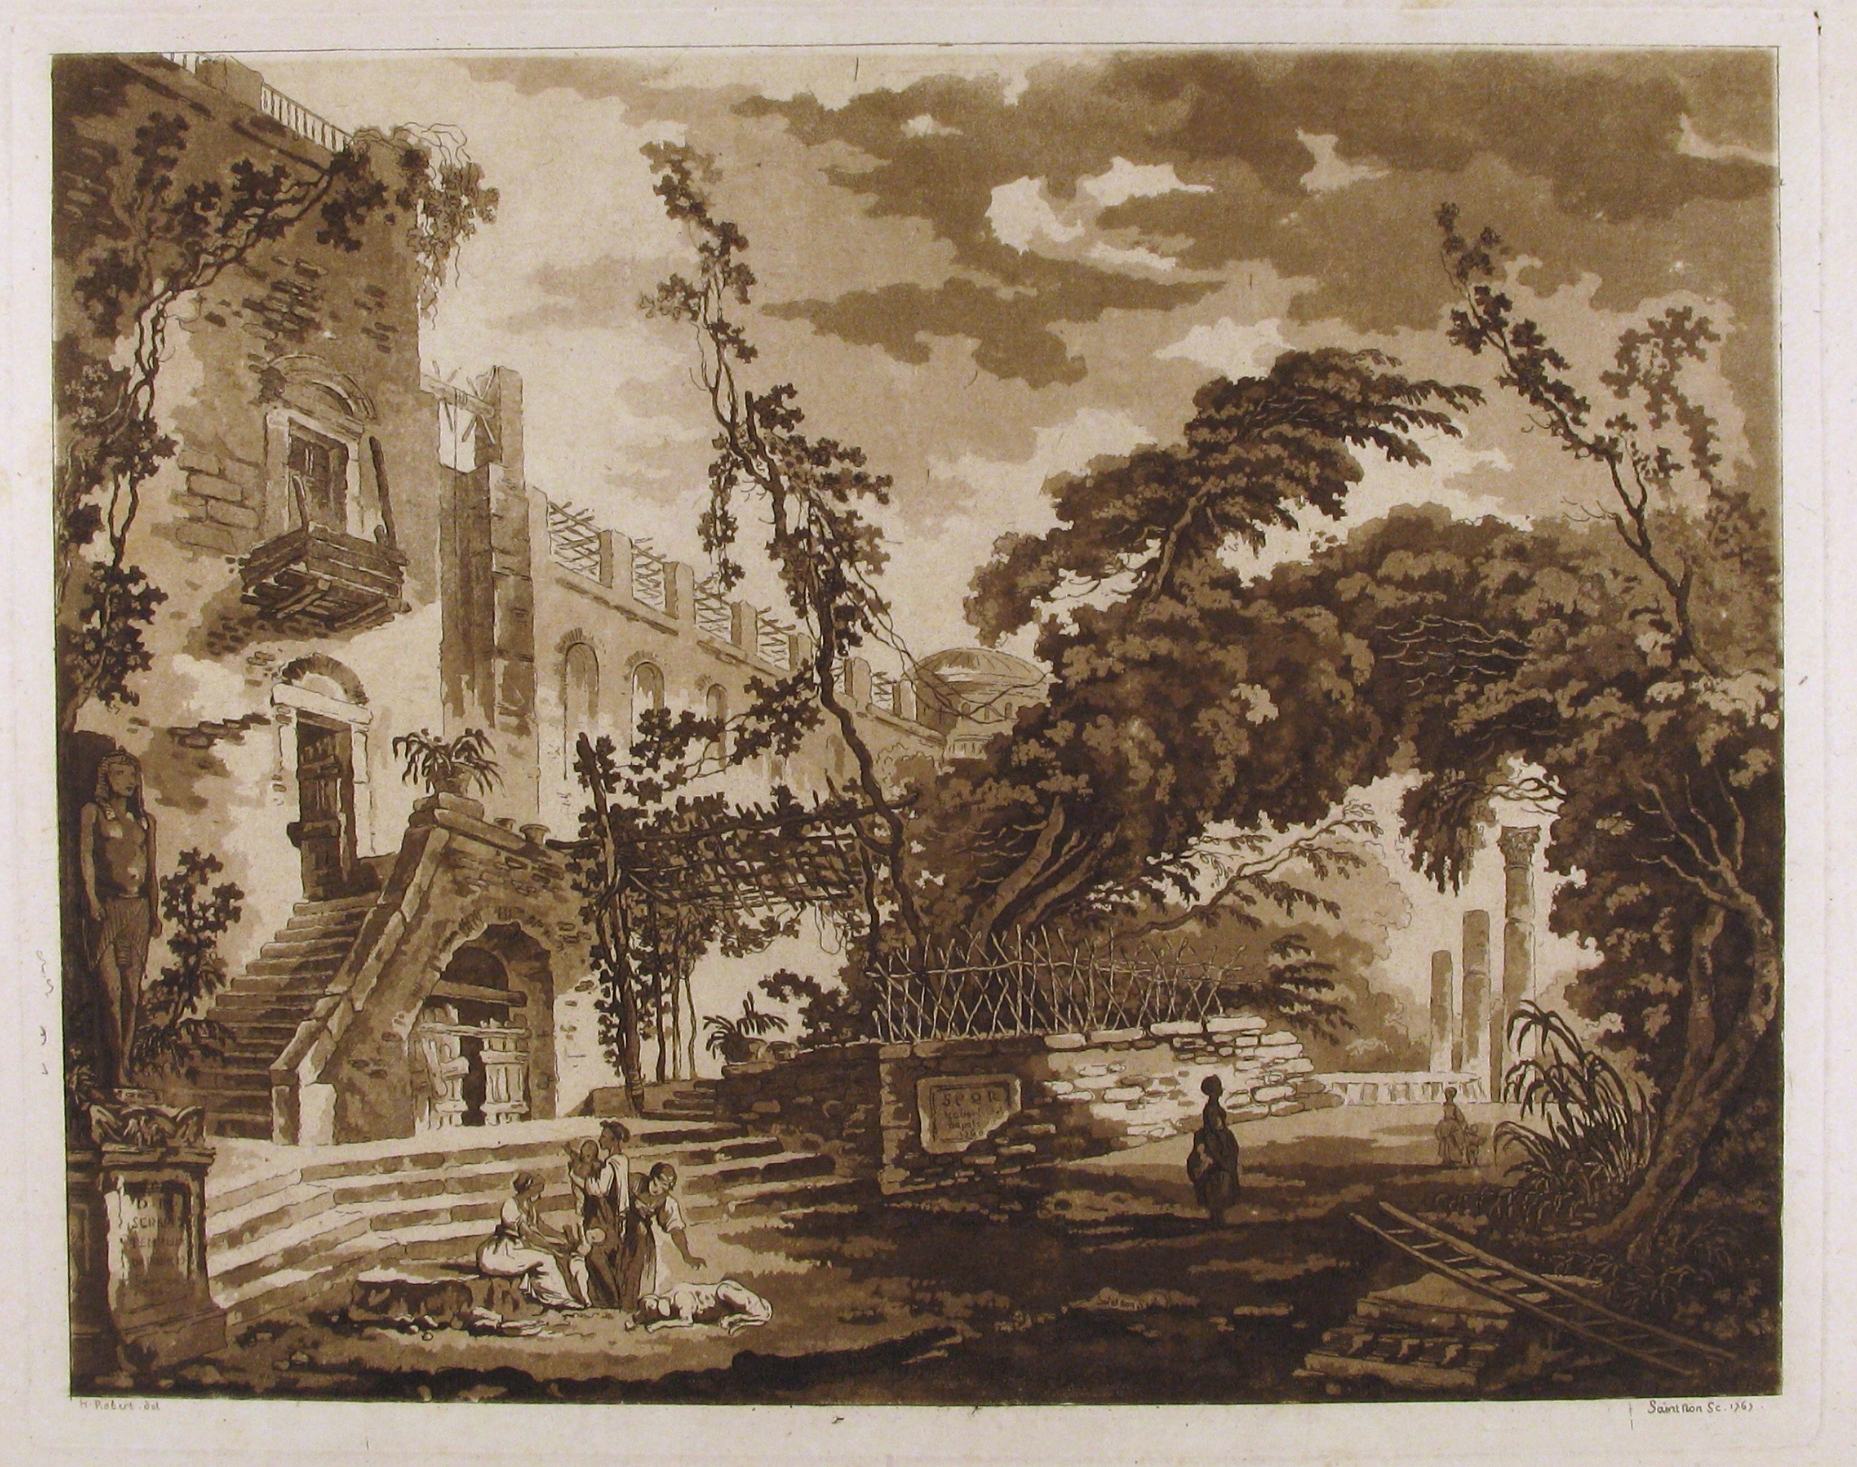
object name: print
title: Tempio di Serapide a Pozzuoli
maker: jean claude richard, abbé de saint-non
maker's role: artist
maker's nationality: french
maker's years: 1727-1791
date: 1767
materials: ink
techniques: aquatint, printing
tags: buildings,landscapes